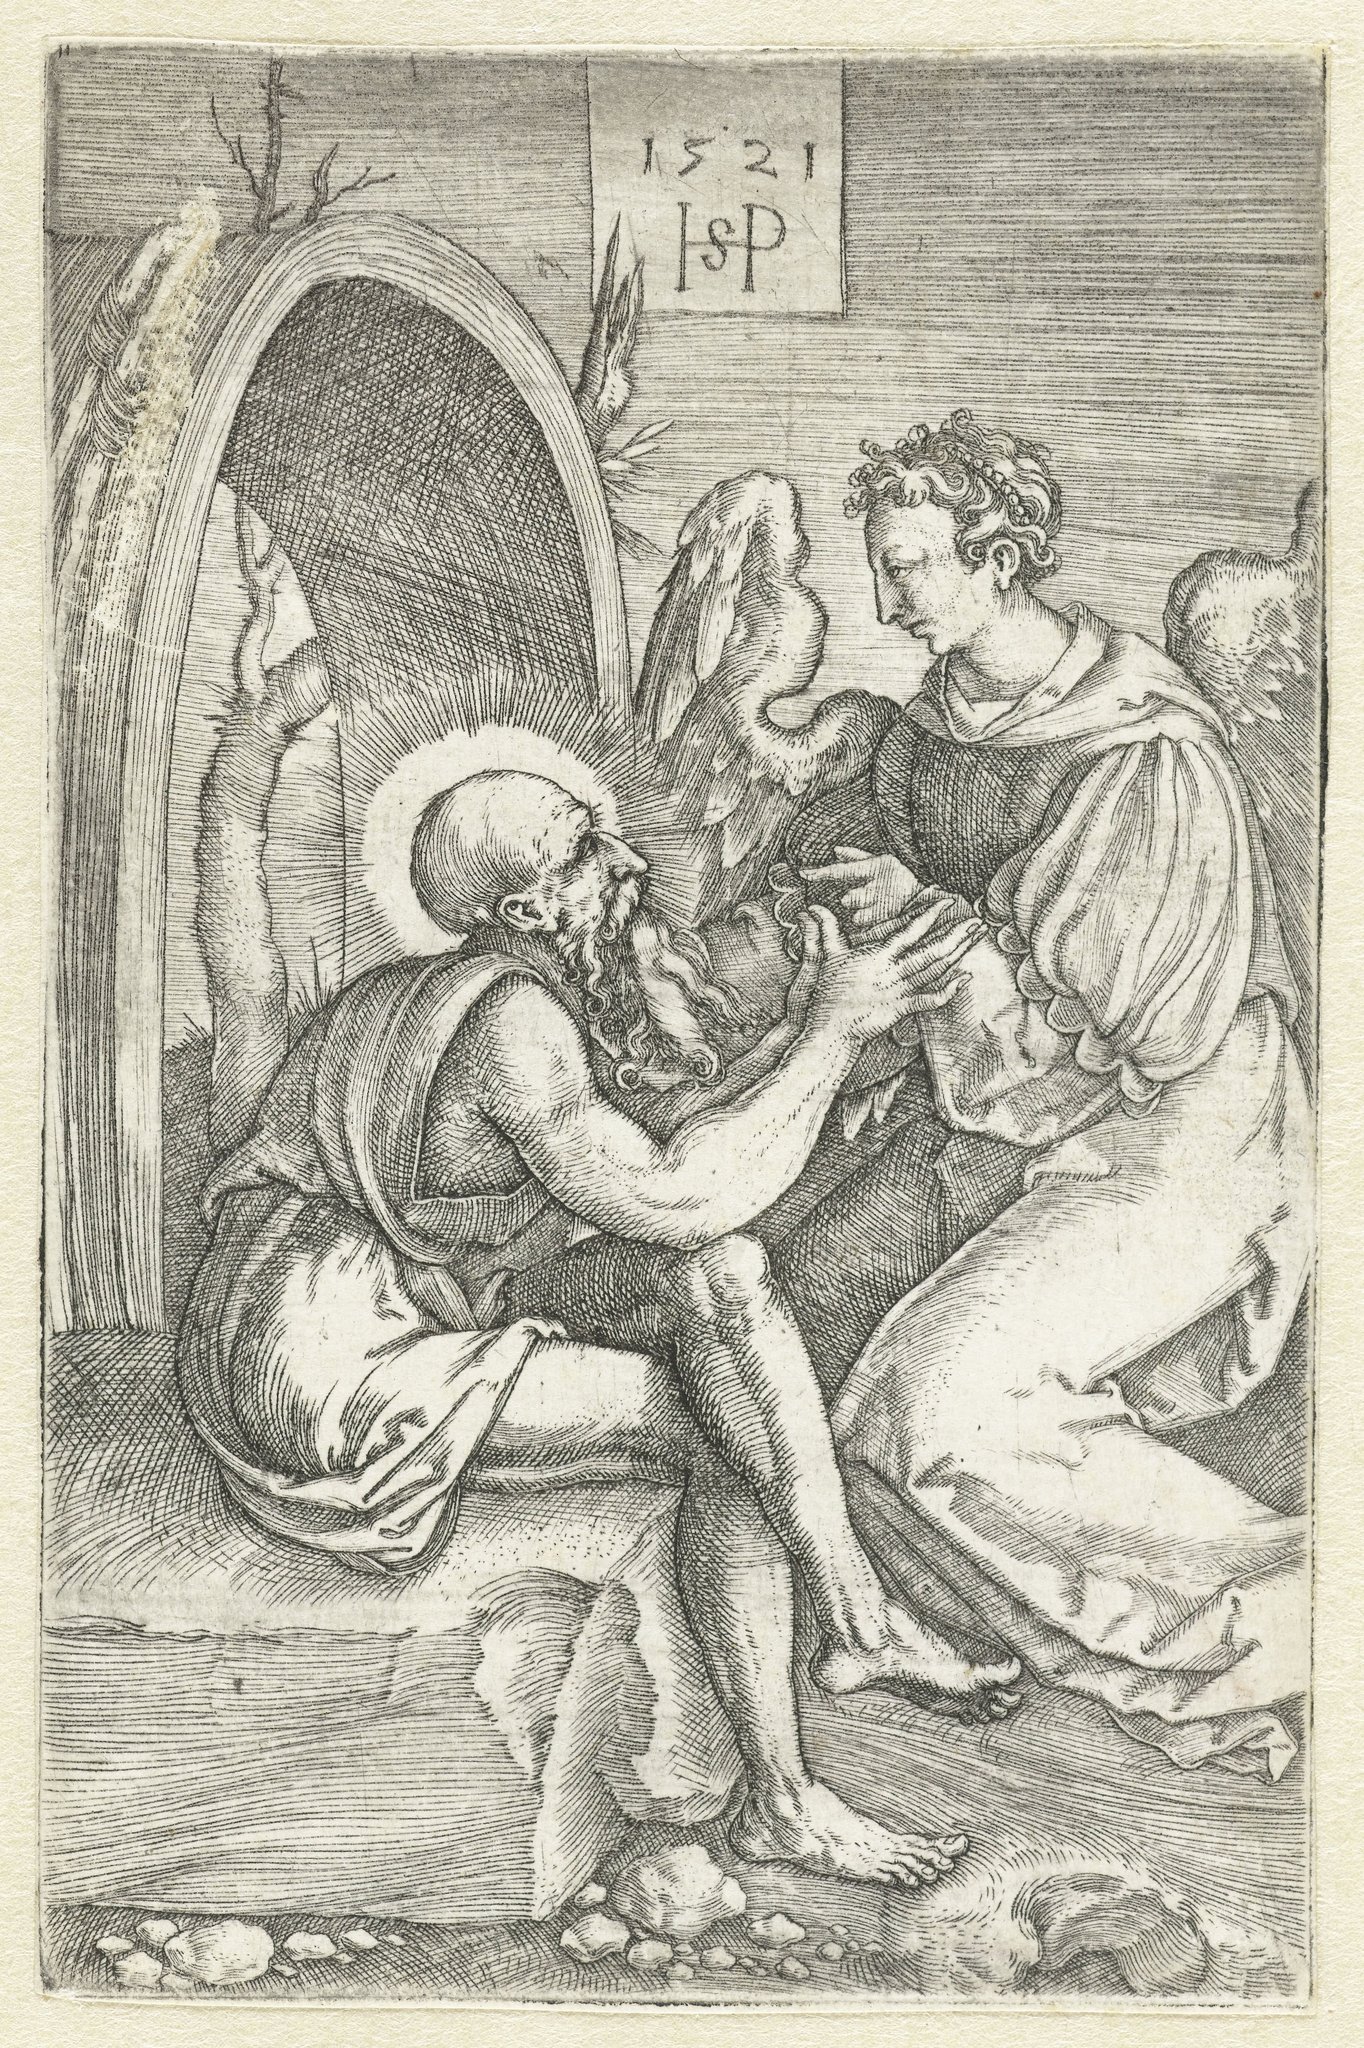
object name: print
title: Heilige Hieronymus in gesprek met een engel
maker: hans sebald beham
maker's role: designer, draughtsman, print maker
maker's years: 1500-1550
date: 1521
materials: paper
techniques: engraving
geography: nuremberg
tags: the monk and hermit jerome (hieronymus); possible attributes: book, cardinal's hat, crucifix, hour-glass, lion, skull, stone, angels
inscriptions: collector's mark: Lugt 240